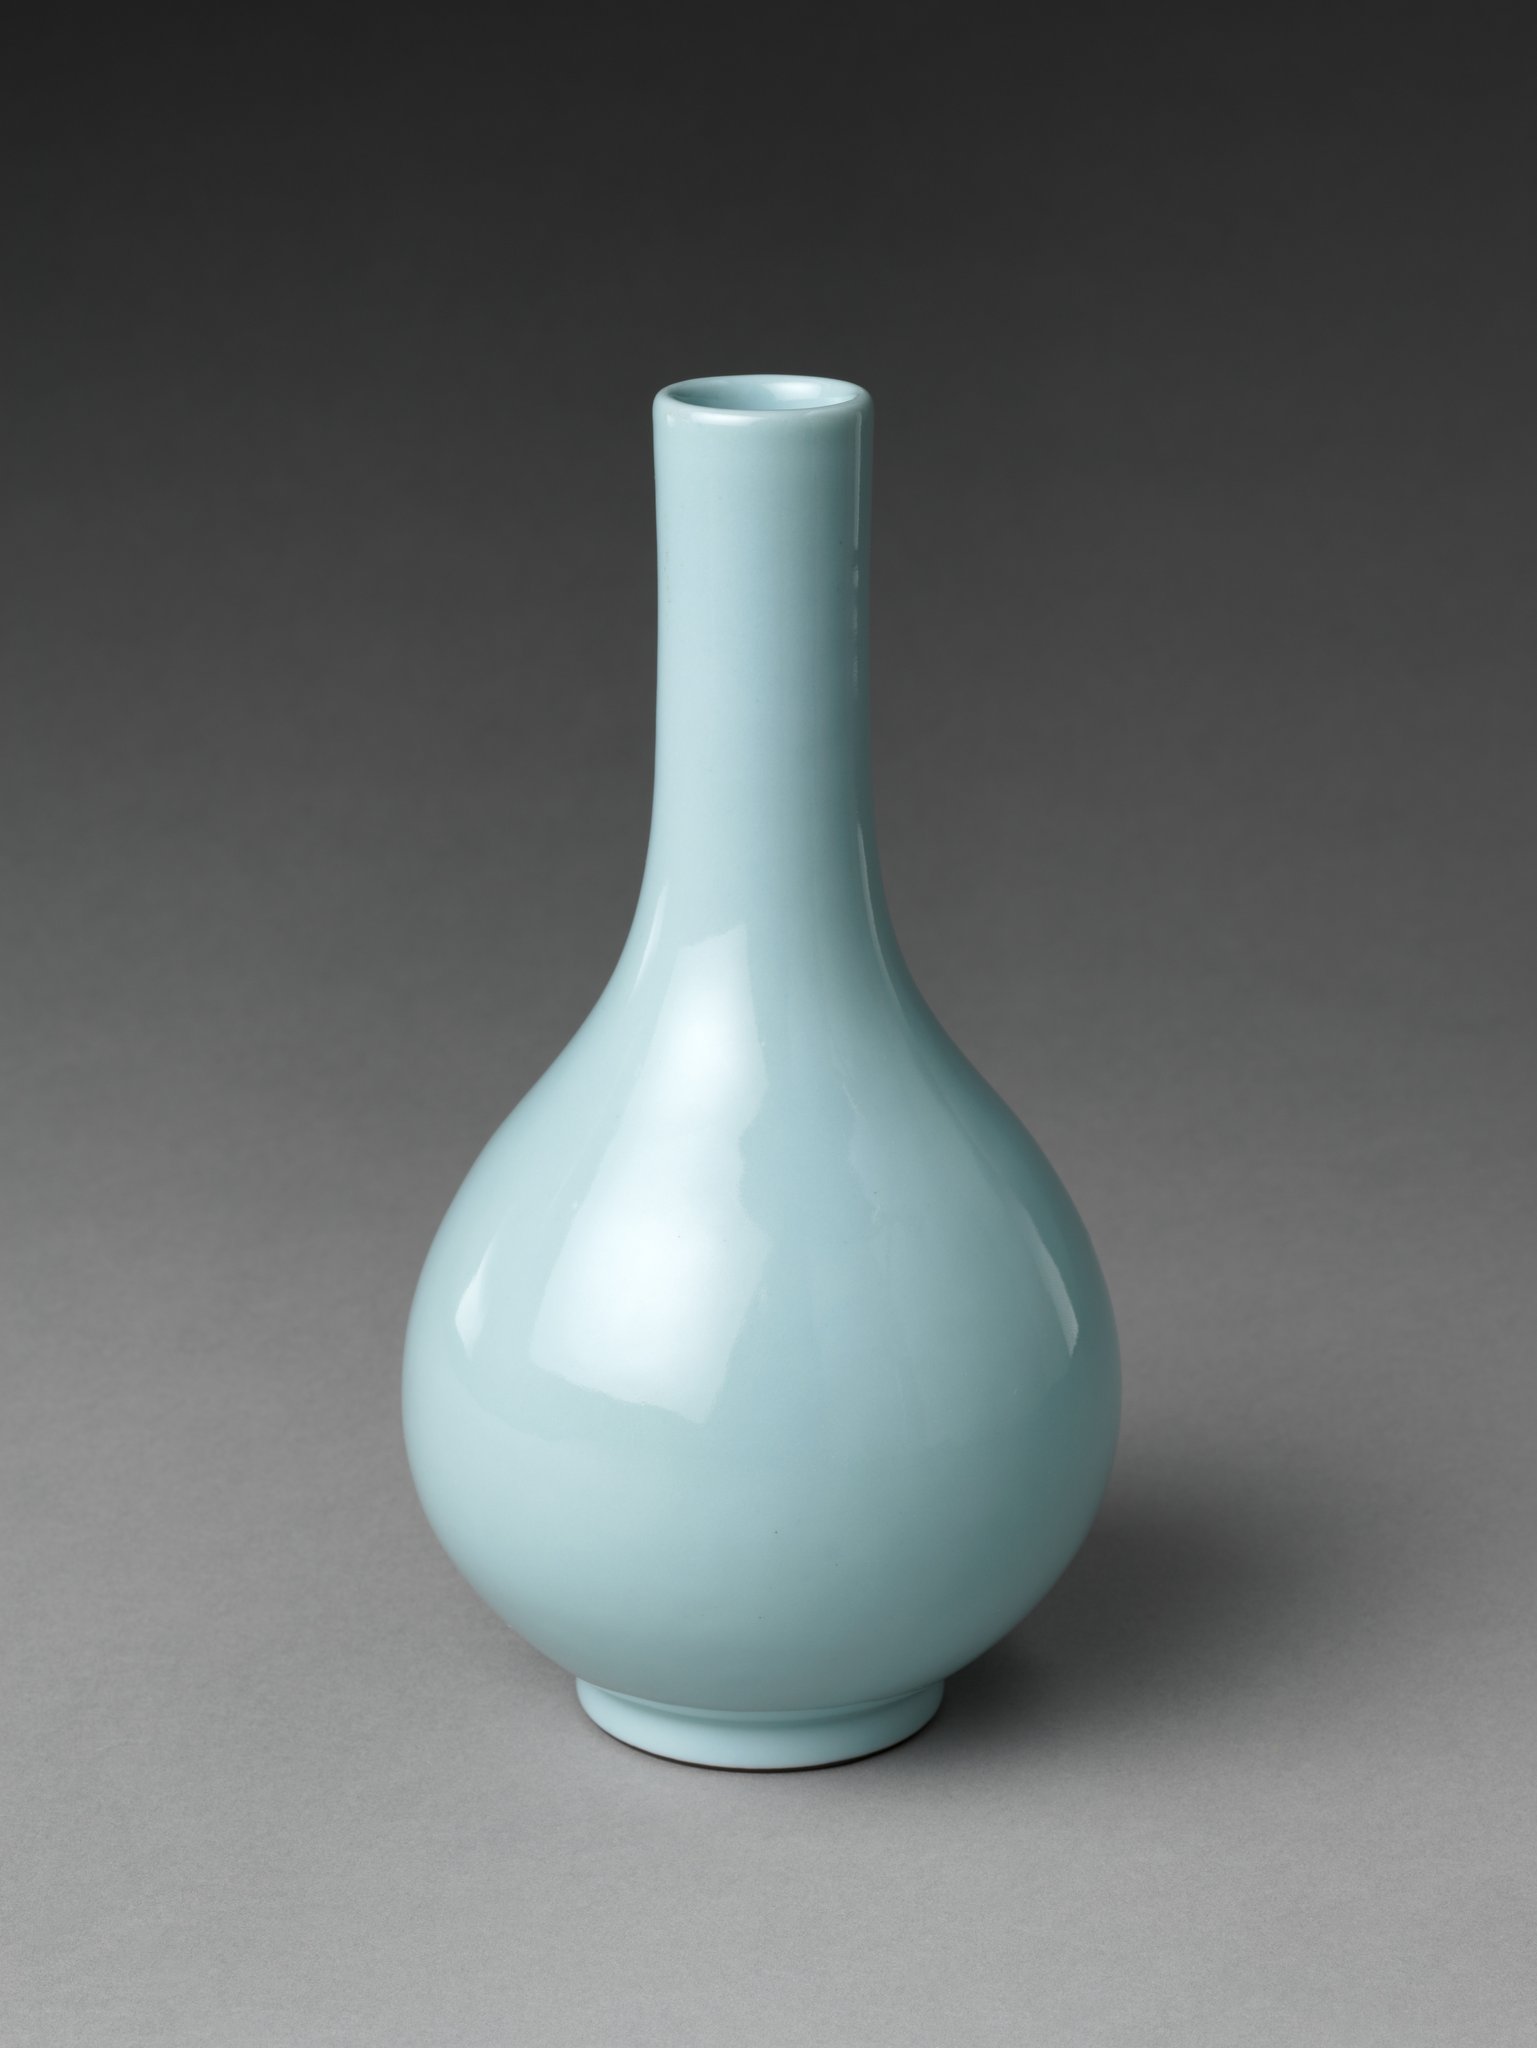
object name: vase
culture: chinese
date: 1701-1800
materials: ceramic glaze, glaze, porcelain